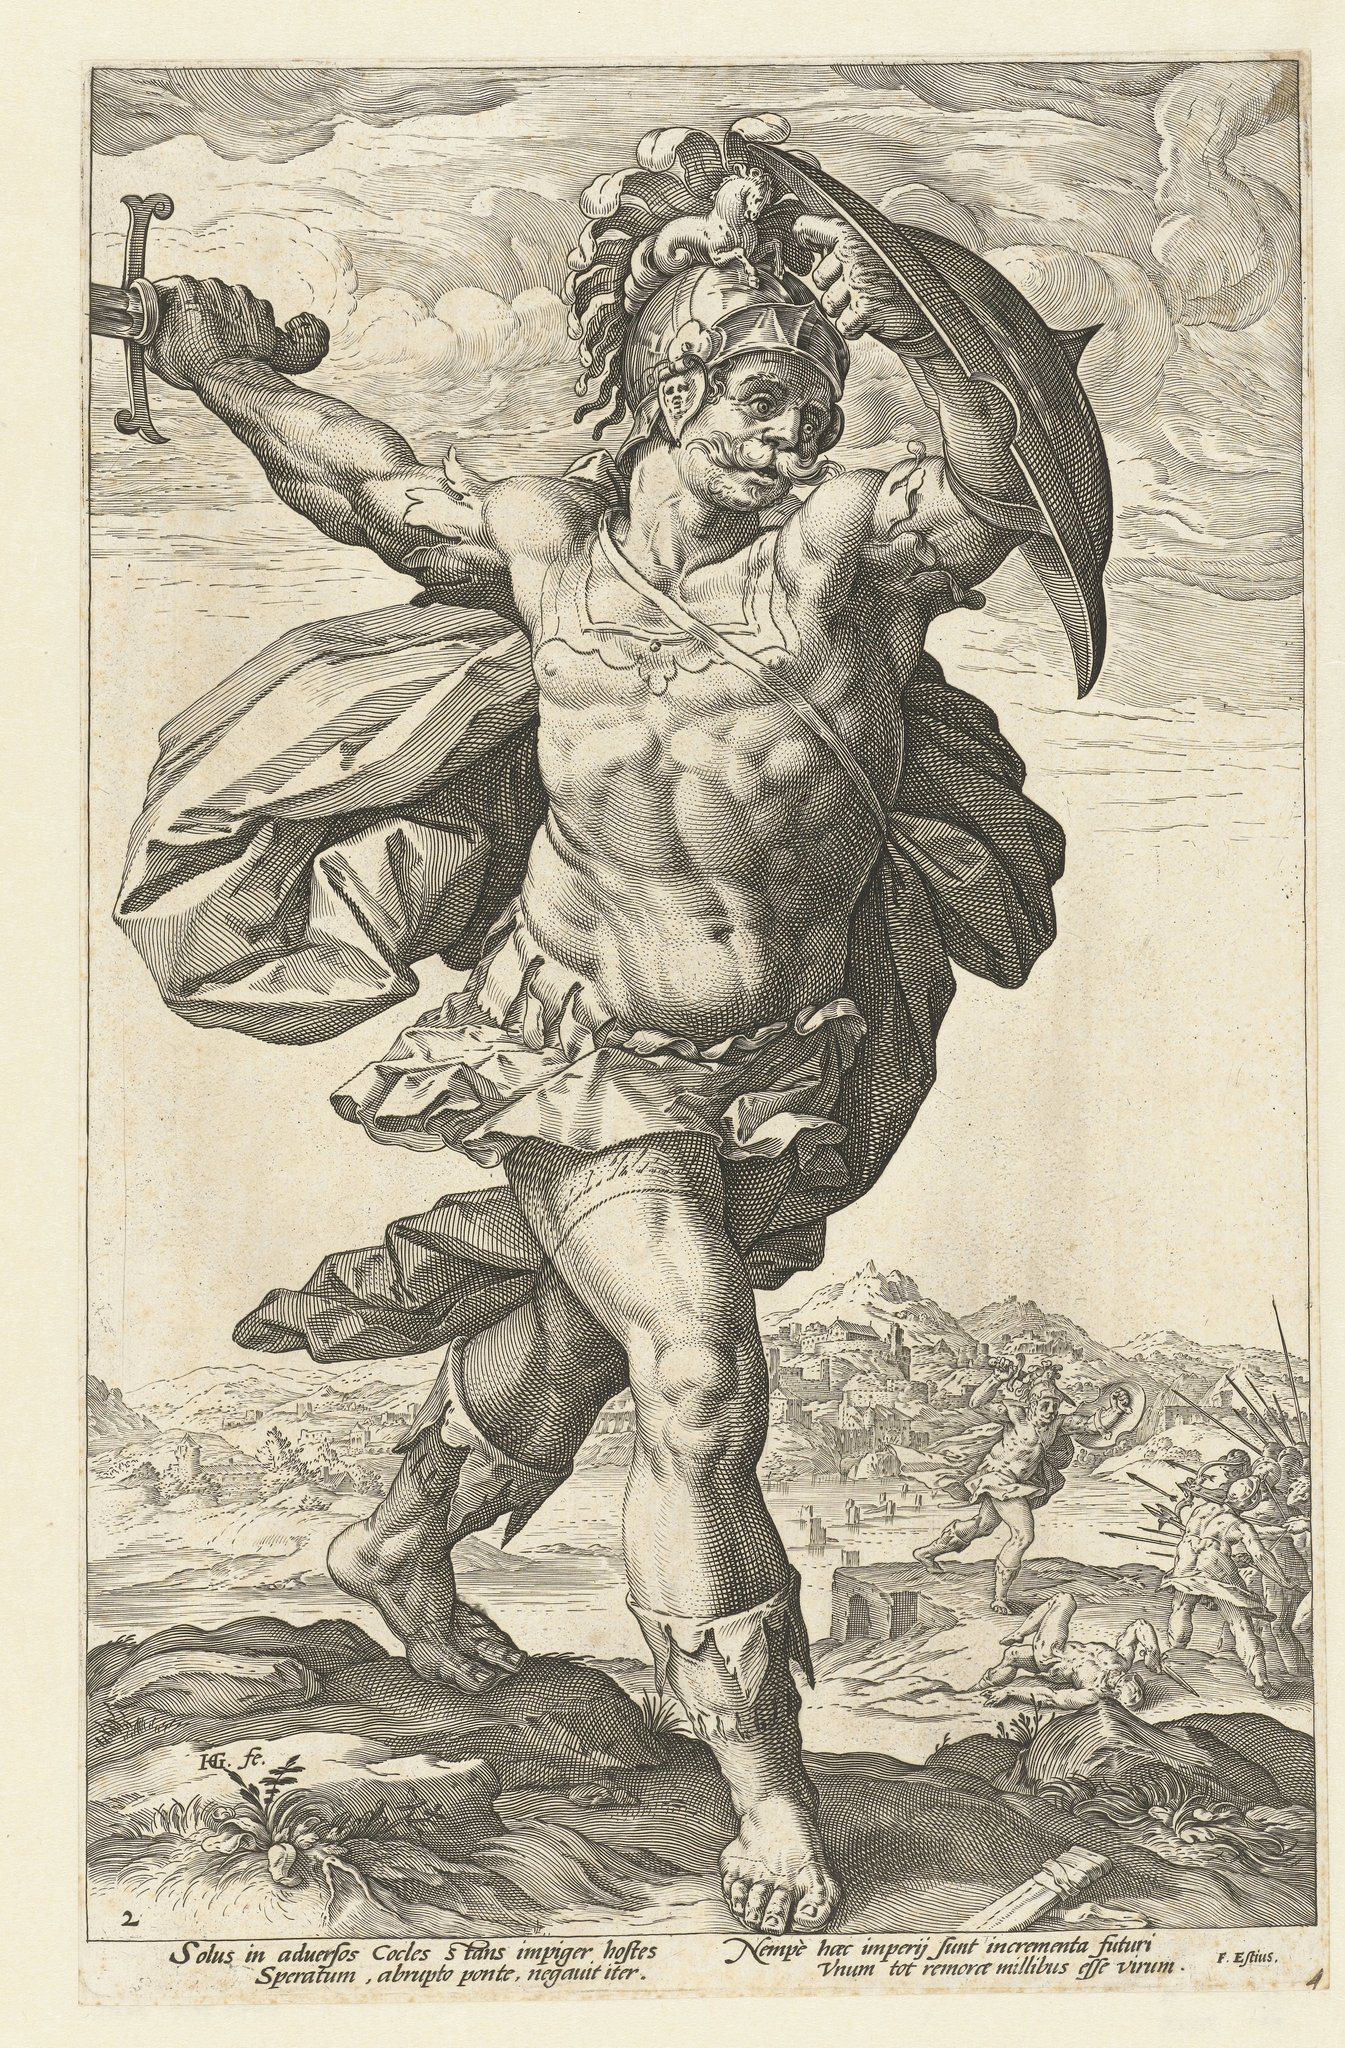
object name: print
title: Horatius Cocles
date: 1586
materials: paper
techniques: engraving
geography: haarlem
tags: horatius cocles at the pons sublicius: single-handed he keeps the etruscans at bay while the bridge is broken down by the romans behind him; he escapes by jumping into the tiber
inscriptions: collector's mark: Lugt 10, collector's mark: ‘Hinloopen’, collector's mark: Lugt 11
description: De held Horatius Cocles ten voeten uit, een zwaard opgeheven in de rechterhand, een schild in de linkerhand. Op de achtergrond is te zien hoe hij het op de oever van de Tiber in zijn eentje opneemt tegen een heel leger. Onder de voorstelling twee maal twee versregels in Latijn. Deze prent is onderdeel van een serie van tien prenten, bestaand uit een ongenummerde titelprent, acht genummerde voorstellingen van helden en een ongenummerde afsluitende prent.